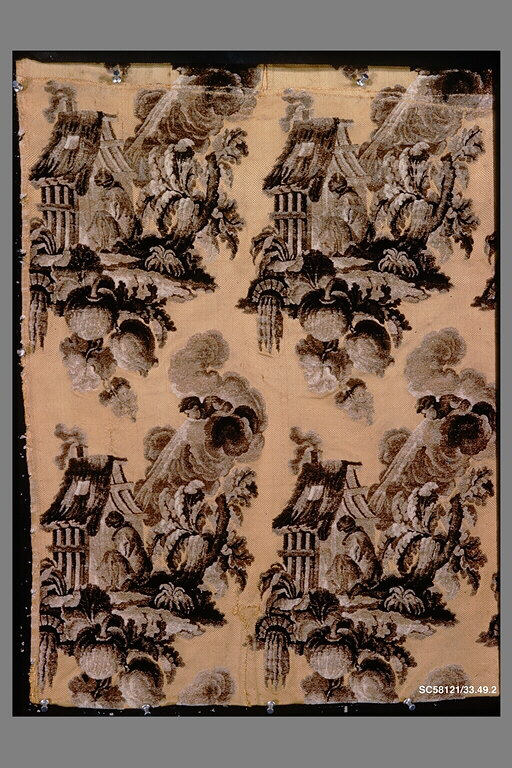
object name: fragment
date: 1701-1733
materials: silk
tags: fruit,plants